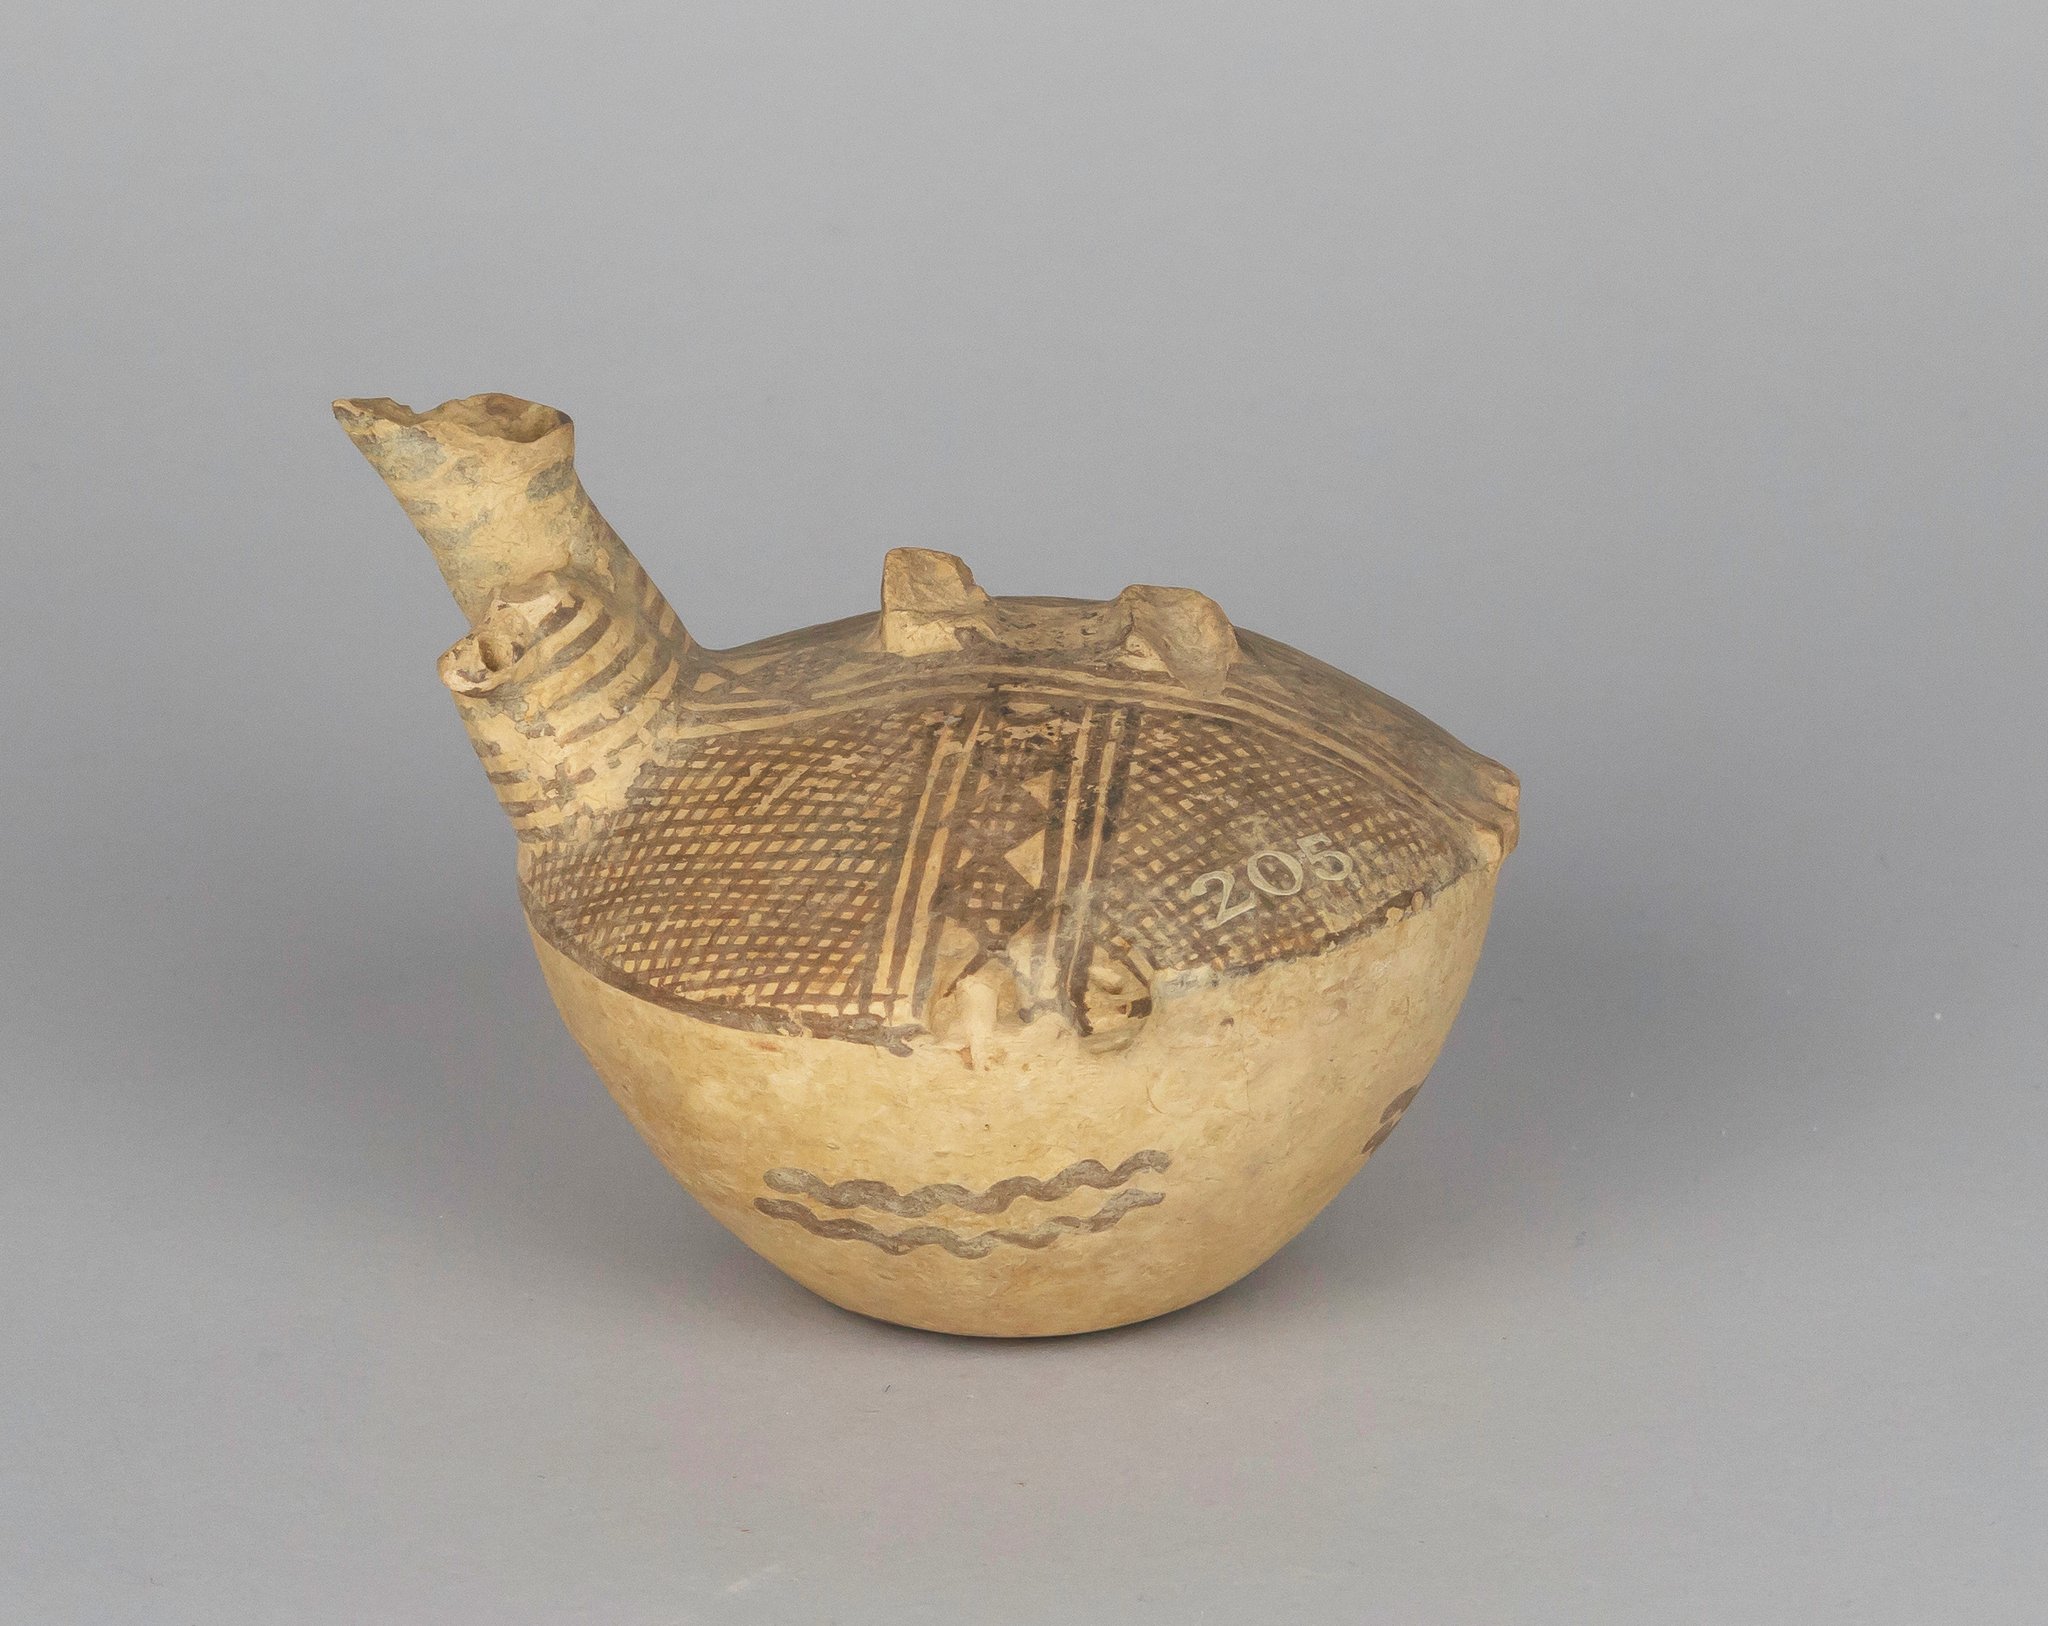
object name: vase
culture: cypriot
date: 3200-1050 BCE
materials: terracotta